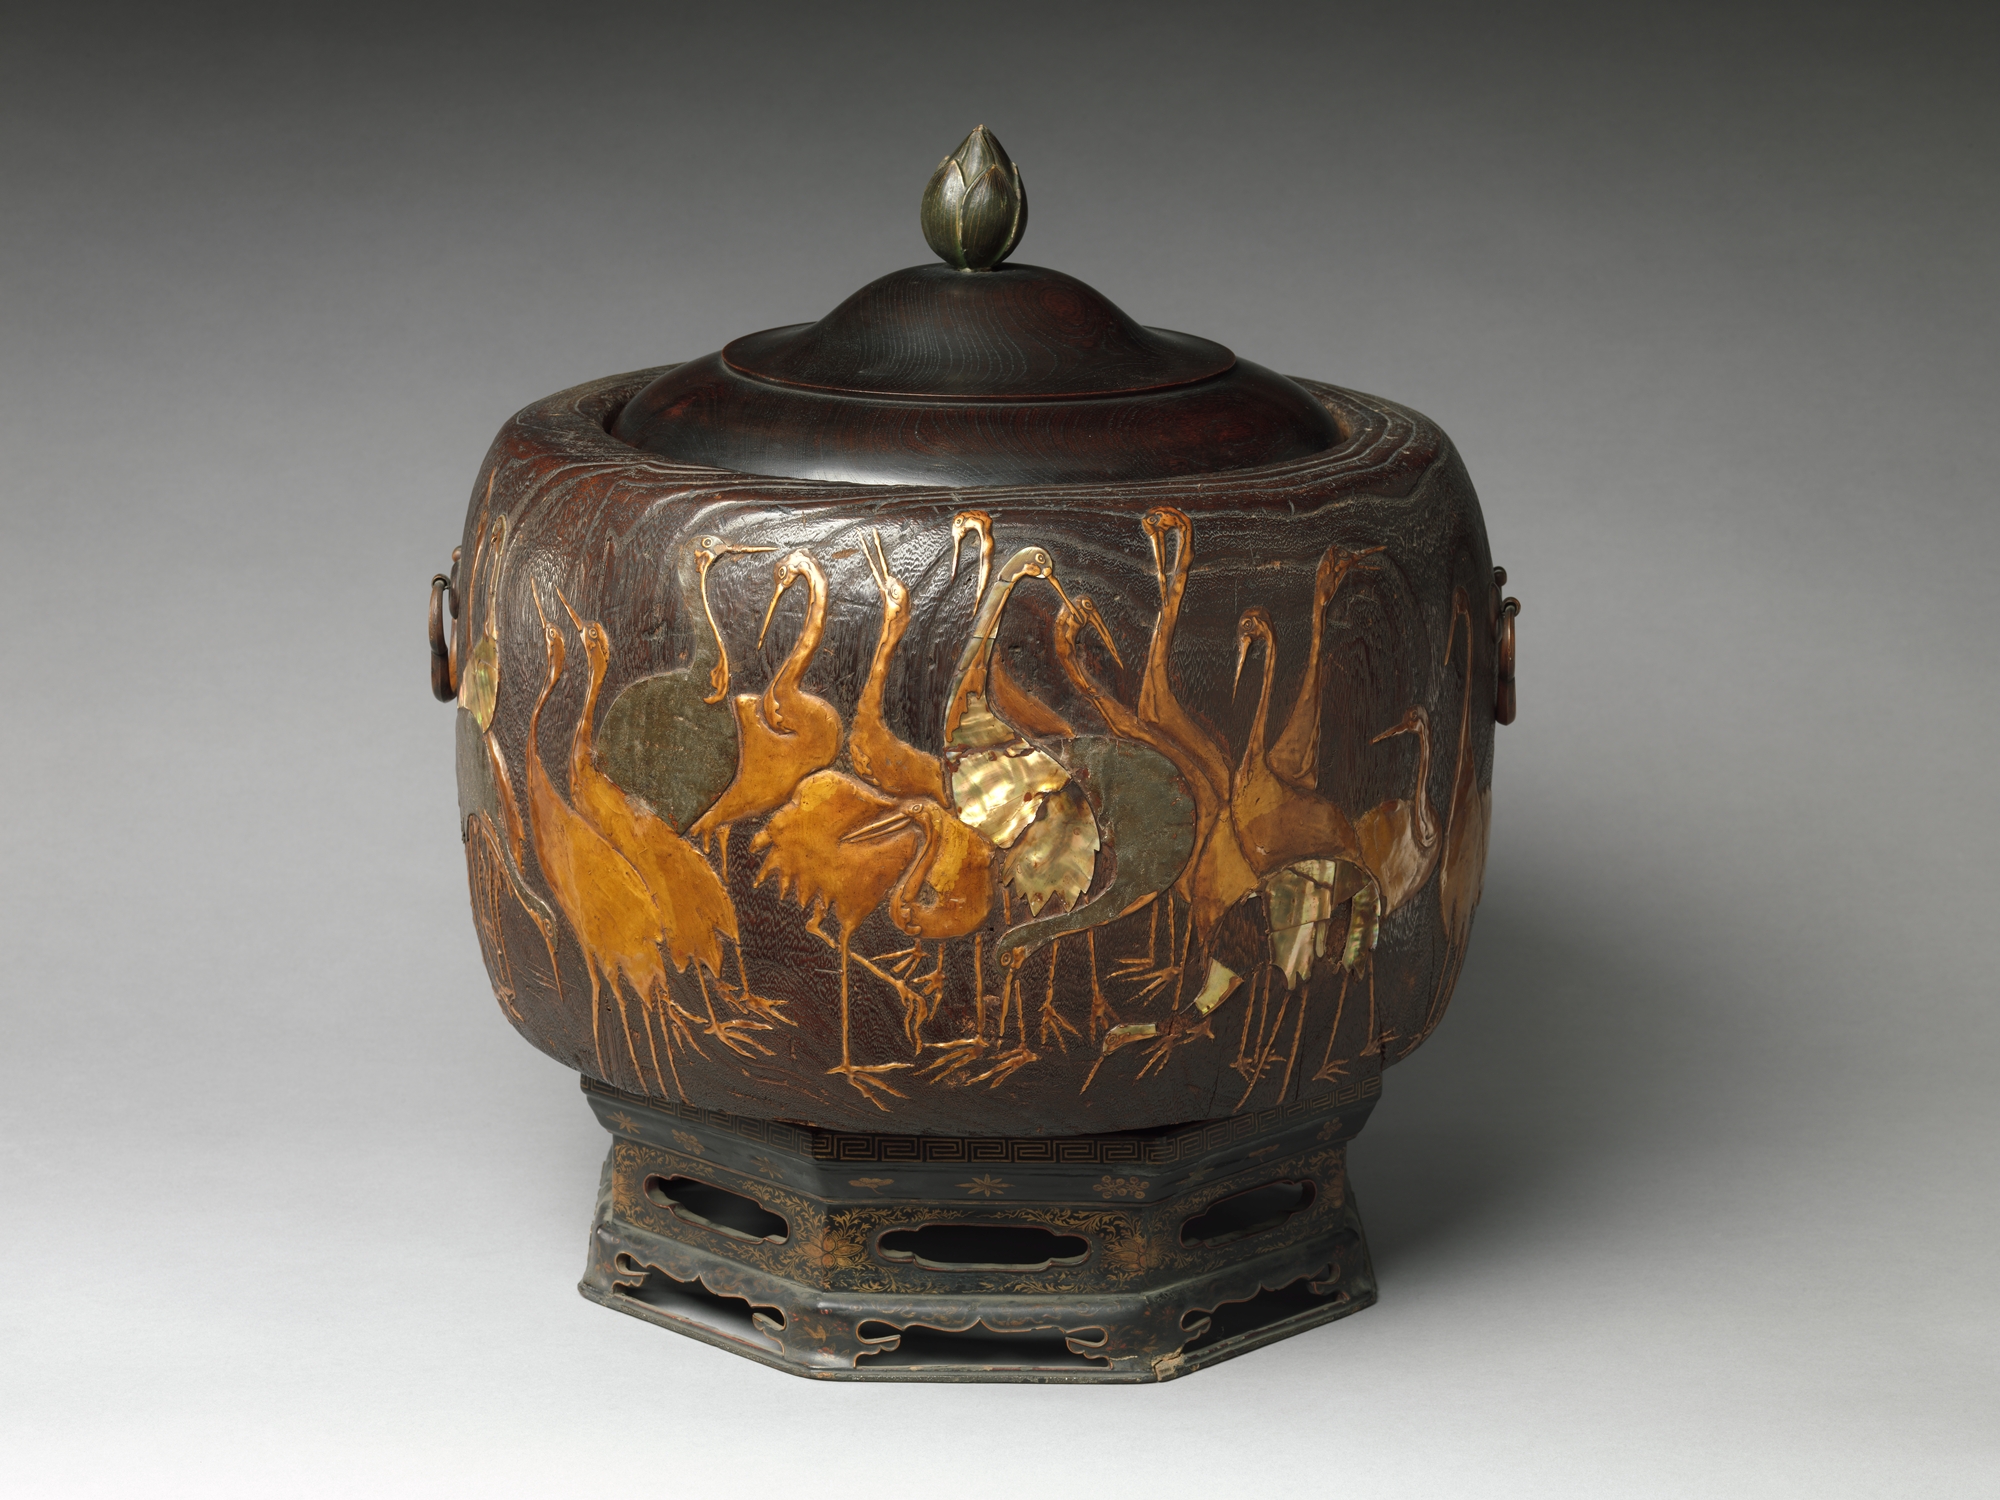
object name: coal container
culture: japanese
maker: ogata kōrin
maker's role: artist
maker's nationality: japanese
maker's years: 1658-1716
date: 1701-1800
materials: lacquer, metal, mother of pearl, wood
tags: cranes